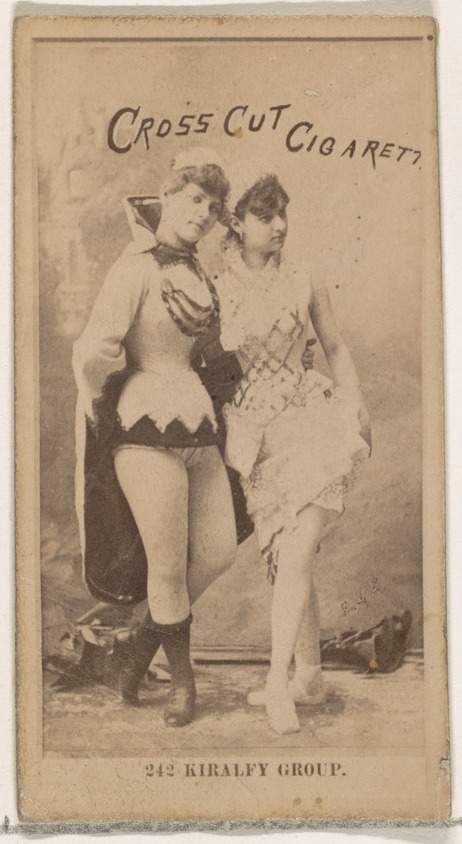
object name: print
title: Card Number 242, Kiralfy Group, from the Actors and Actresses series (N145-2) issued by Duke Sons & Co. to promote Cross Cut Cigarettes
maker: w. duke, sons & co.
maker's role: publisher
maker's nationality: american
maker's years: 1870-1920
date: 1880-1889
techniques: albumen silver print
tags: portraits,women,actresses